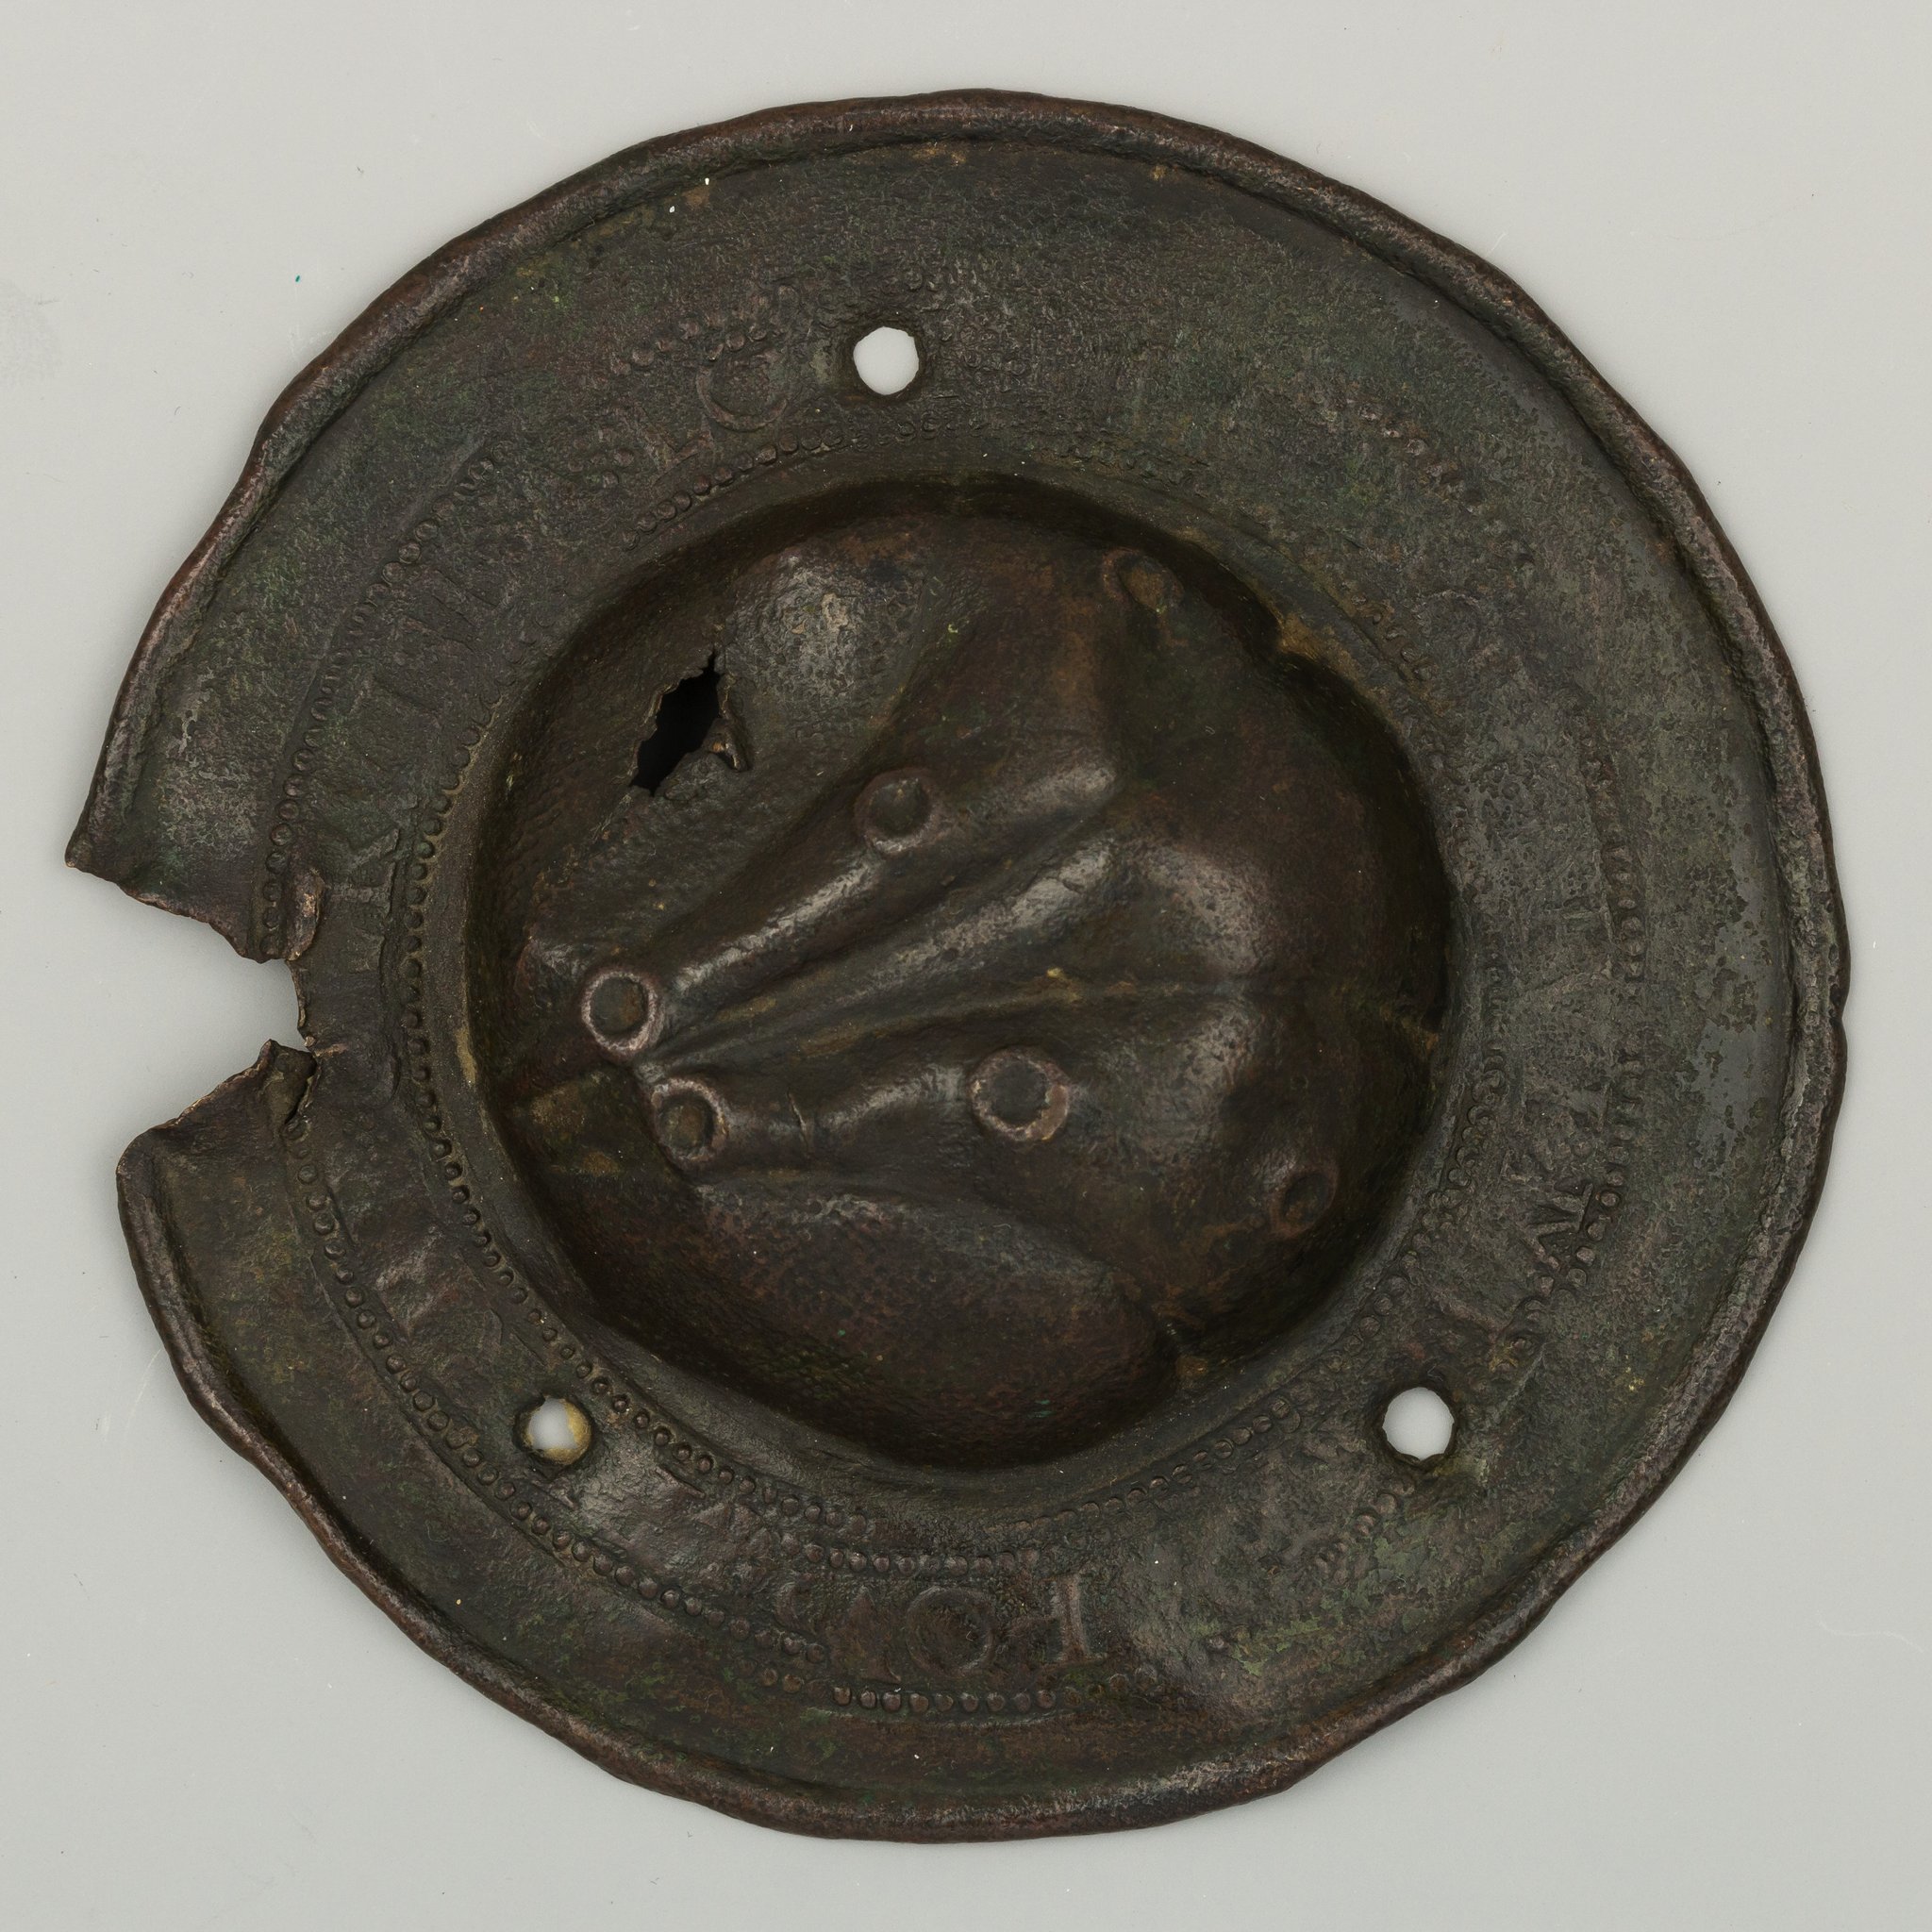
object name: bit bos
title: Bit Boss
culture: french or south netherlandish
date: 1501-1550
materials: copper alloy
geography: netherlands